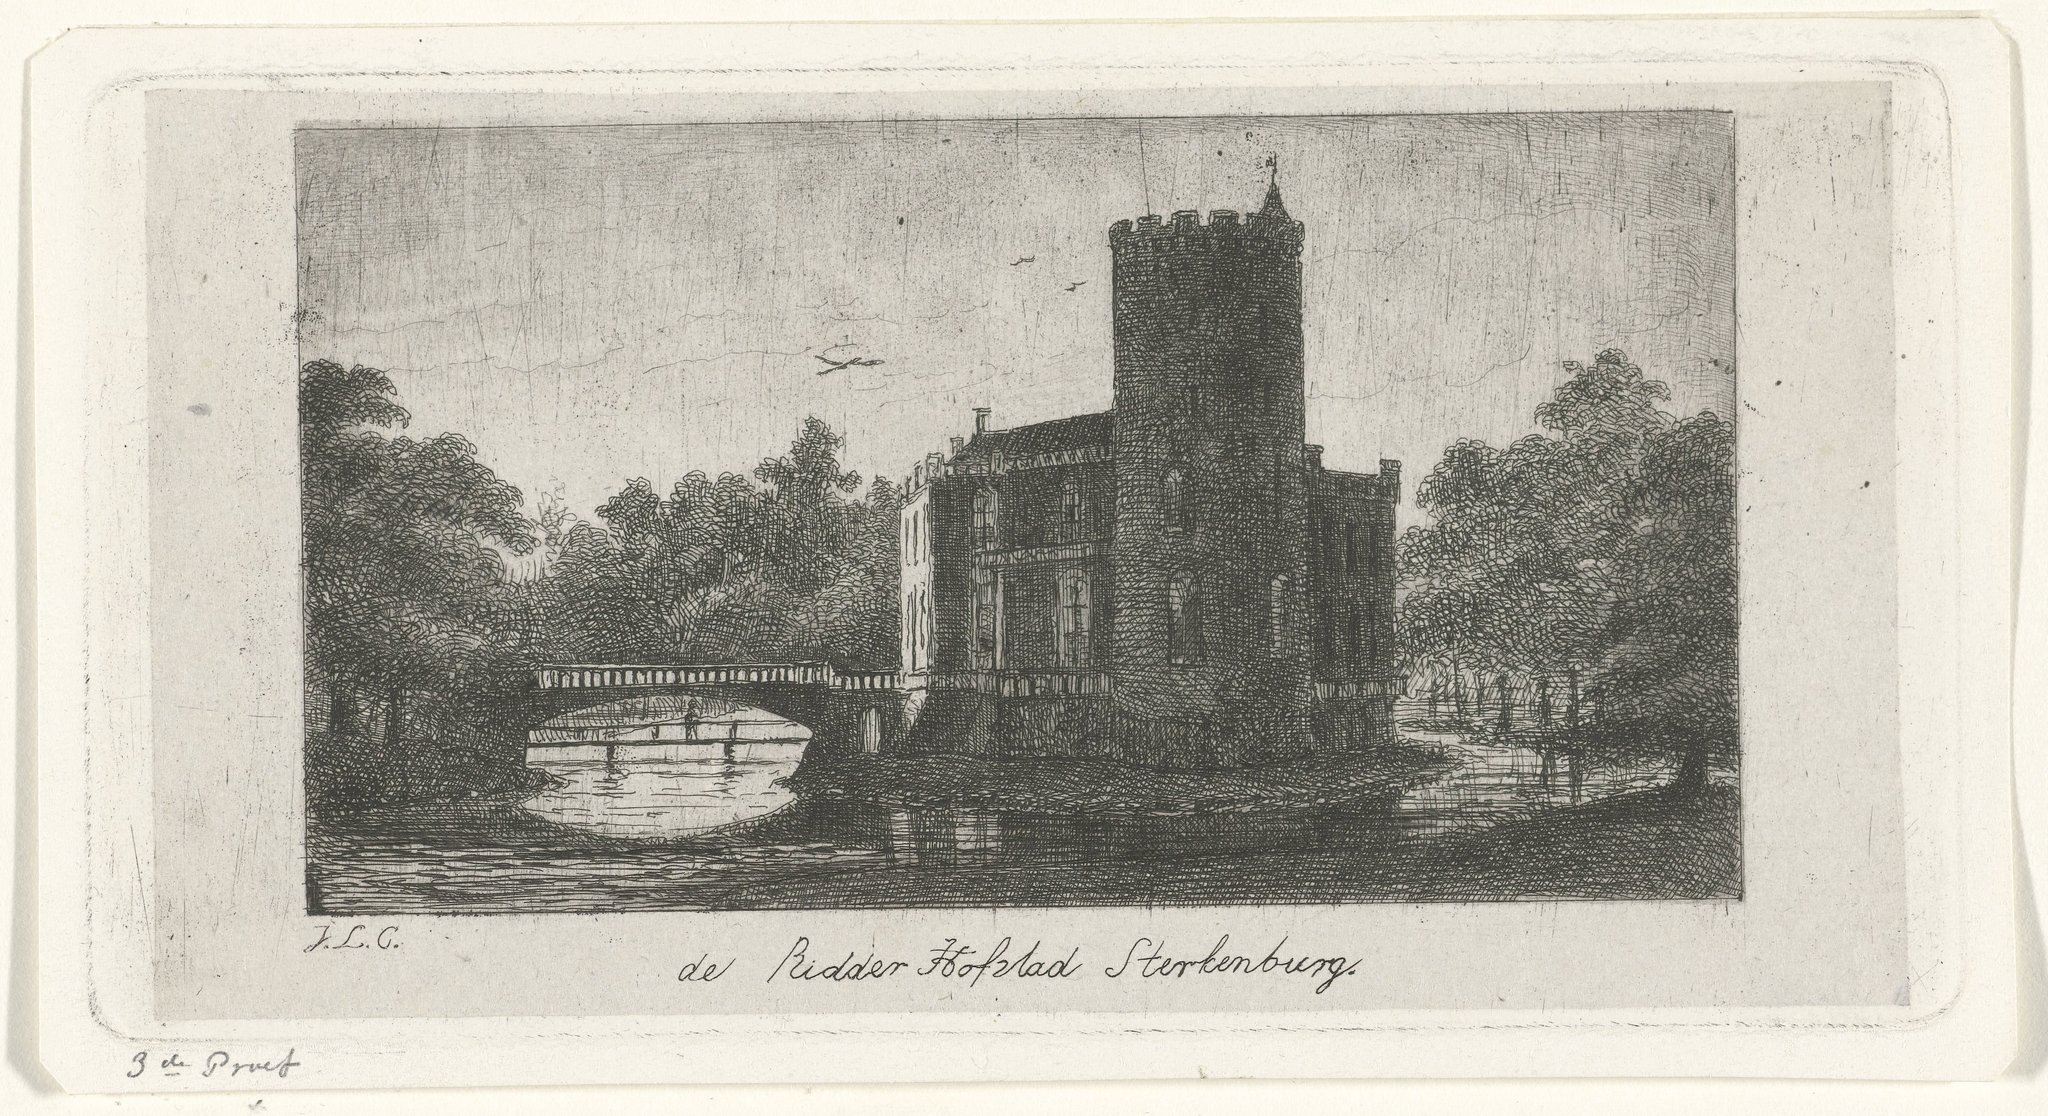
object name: print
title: De ridderhostad Sterkenburg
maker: jacobus ludovicus cornet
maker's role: draughtsman, print maker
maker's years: 1815-1882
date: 1825-1882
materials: paper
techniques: etching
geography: leiden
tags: kasteel sterkenburg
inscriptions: collector's mark: Lugt 2166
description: Gezicht op het kasteel Sterkenburg, met links de brug naar het kasteel.